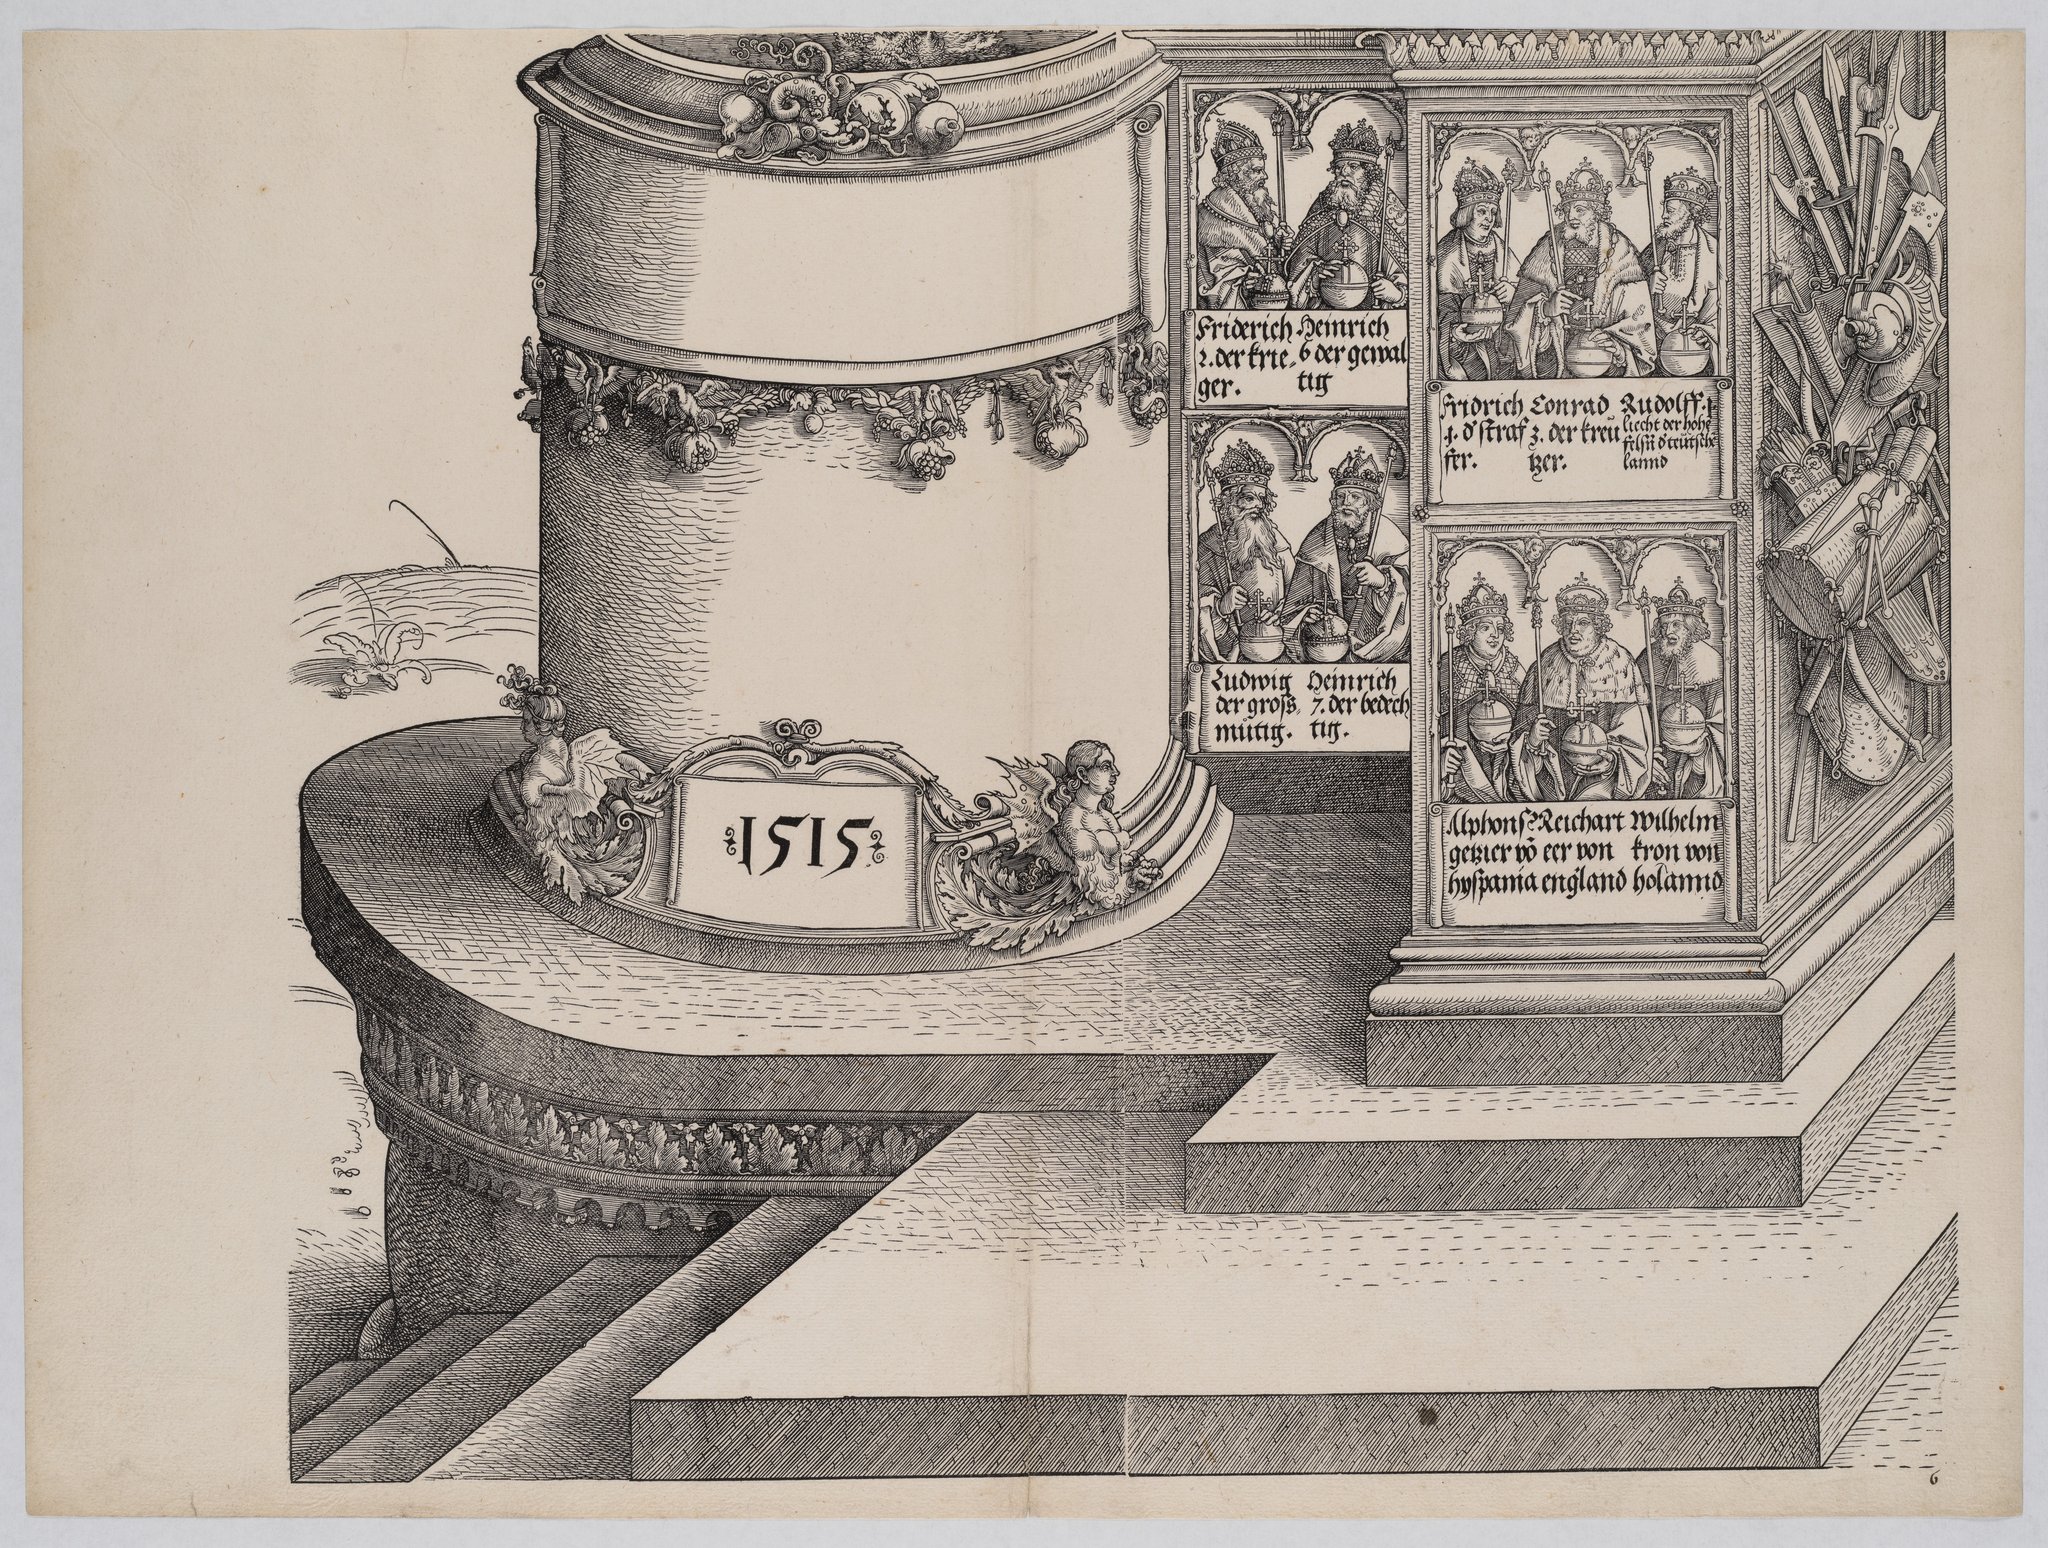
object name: print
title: Portraits of Maximilian's Relatives; and the Base of the Left Outer Column with the Date 1515, from the Arch of Honor, proof, dated 1515, printed 1517-18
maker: albrecht altdorfer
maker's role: artist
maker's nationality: german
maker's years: 1480-1538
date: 1515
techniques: letterpress, woodcut